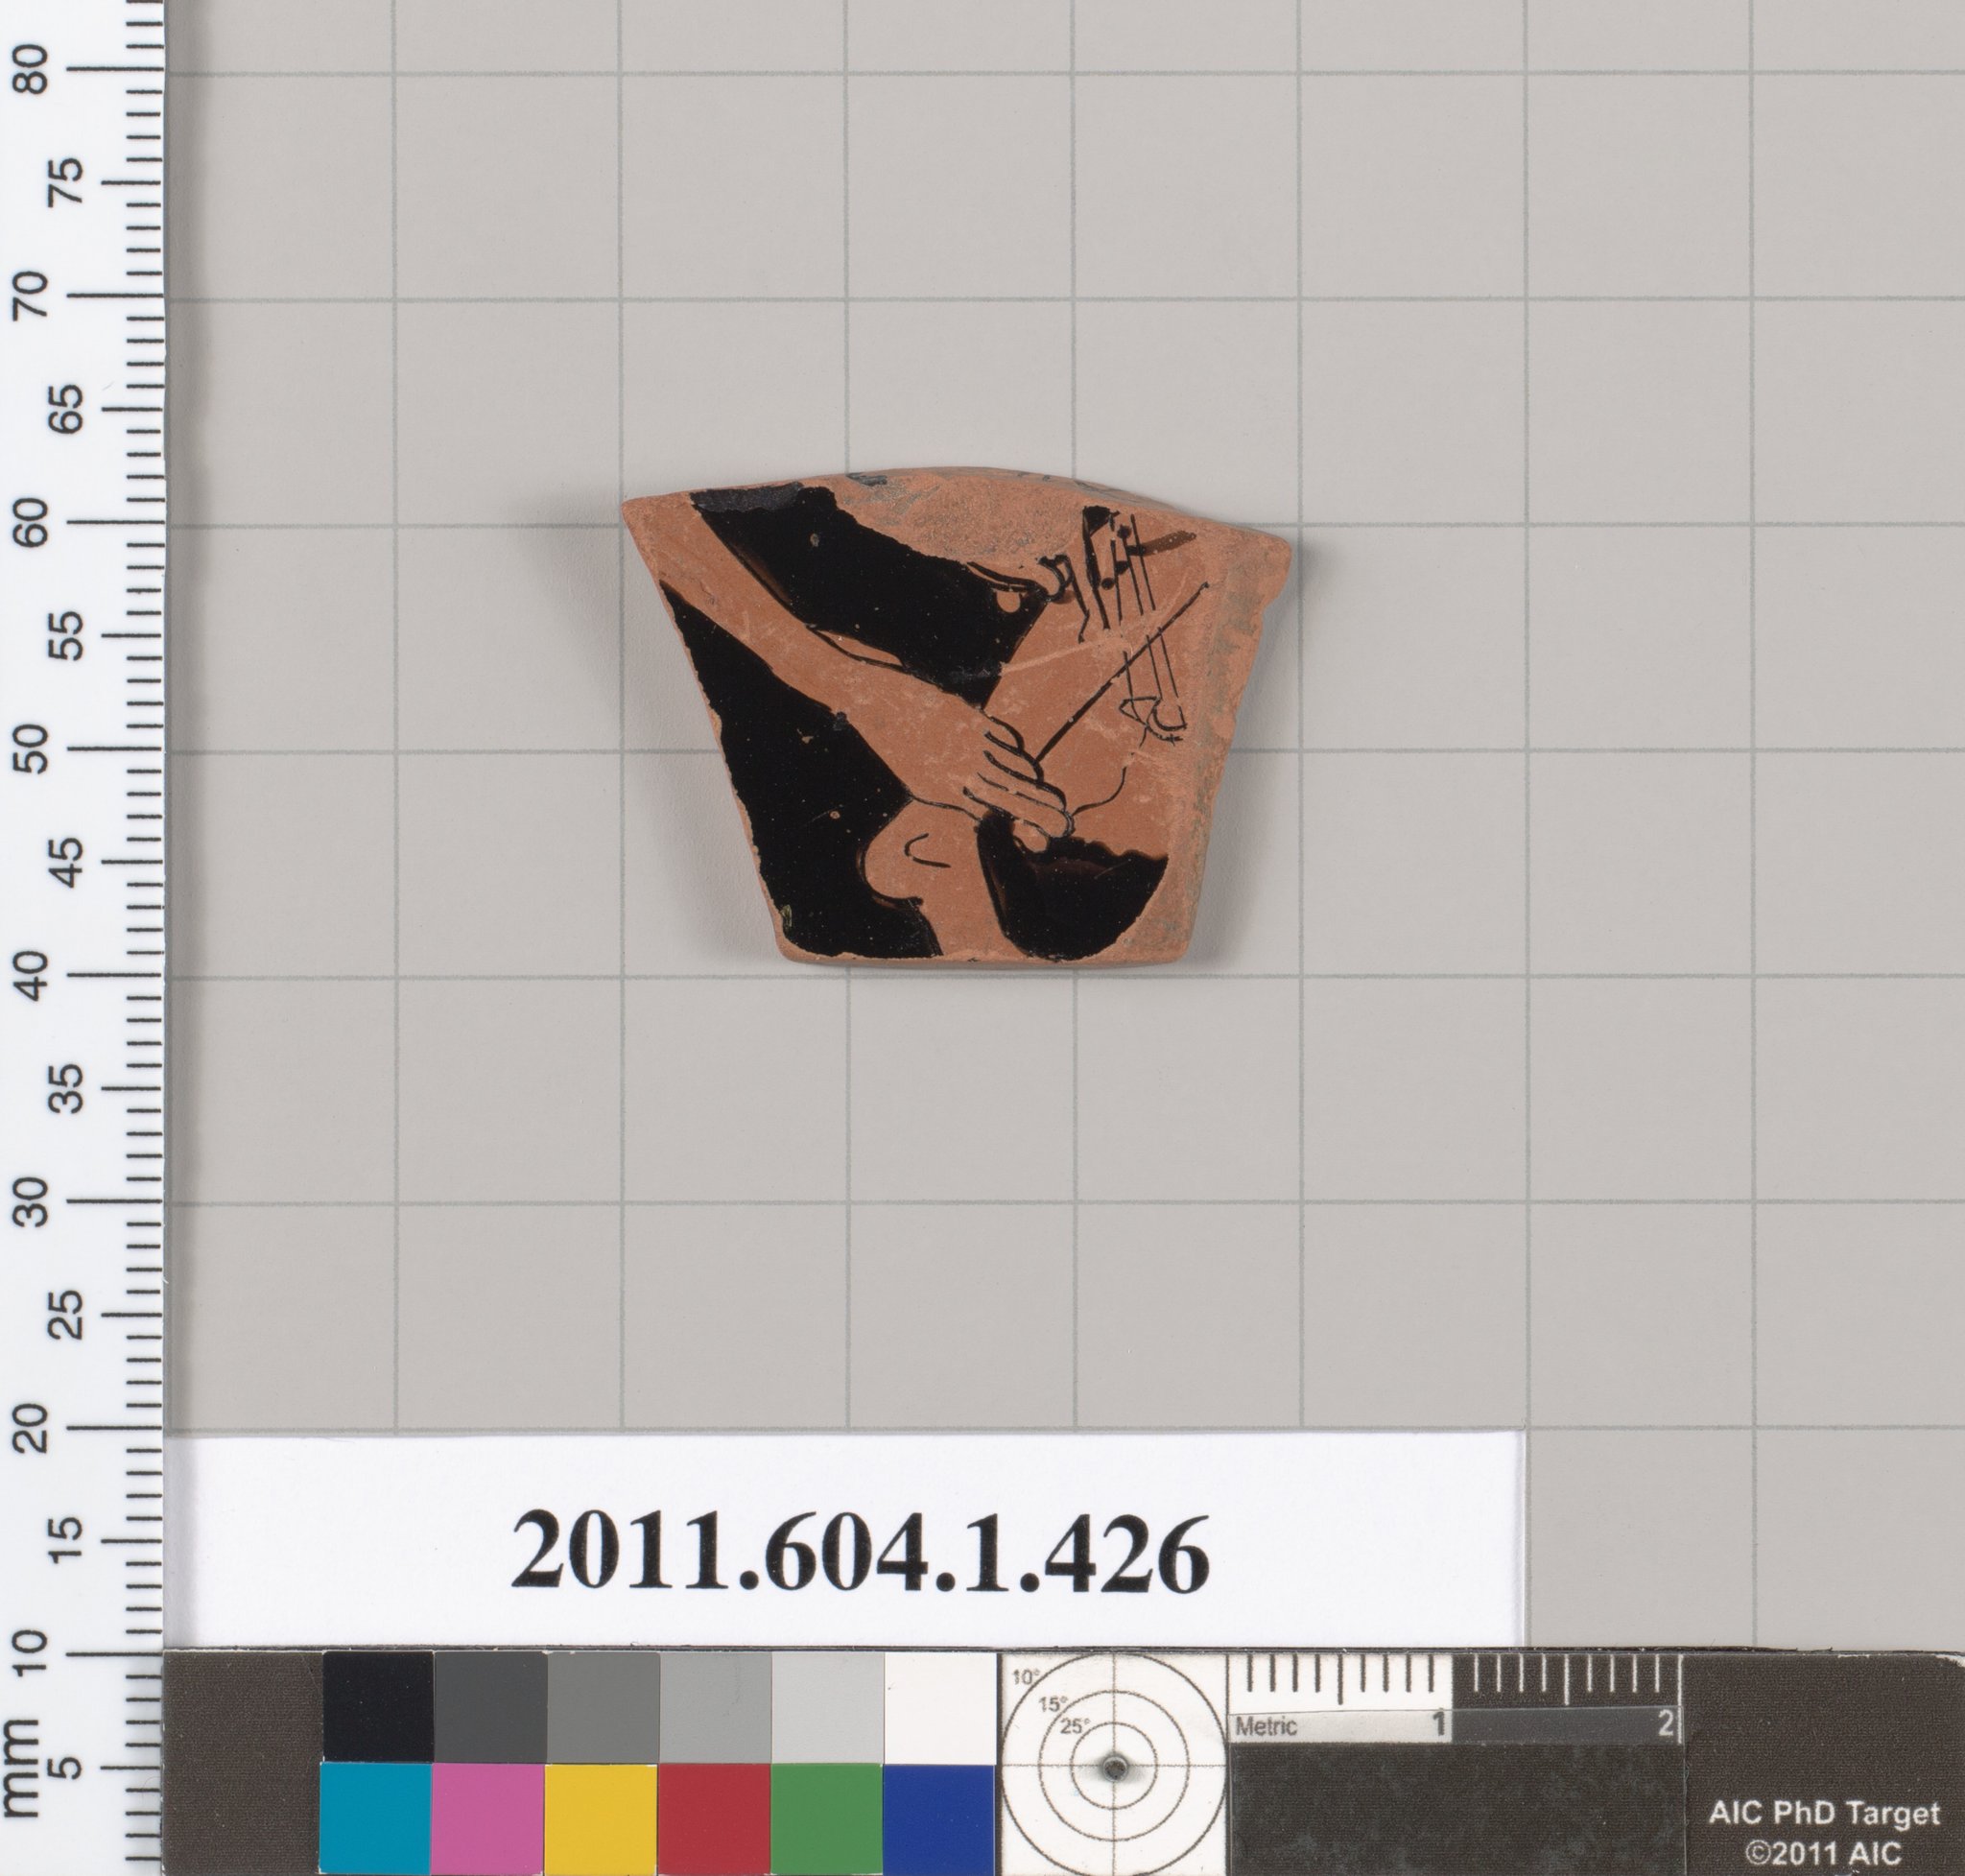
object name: kylix fragment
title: Terracotta fragment of a kylix (drinking cup)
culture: greek, attic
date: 475-451 BCE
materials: terracotta